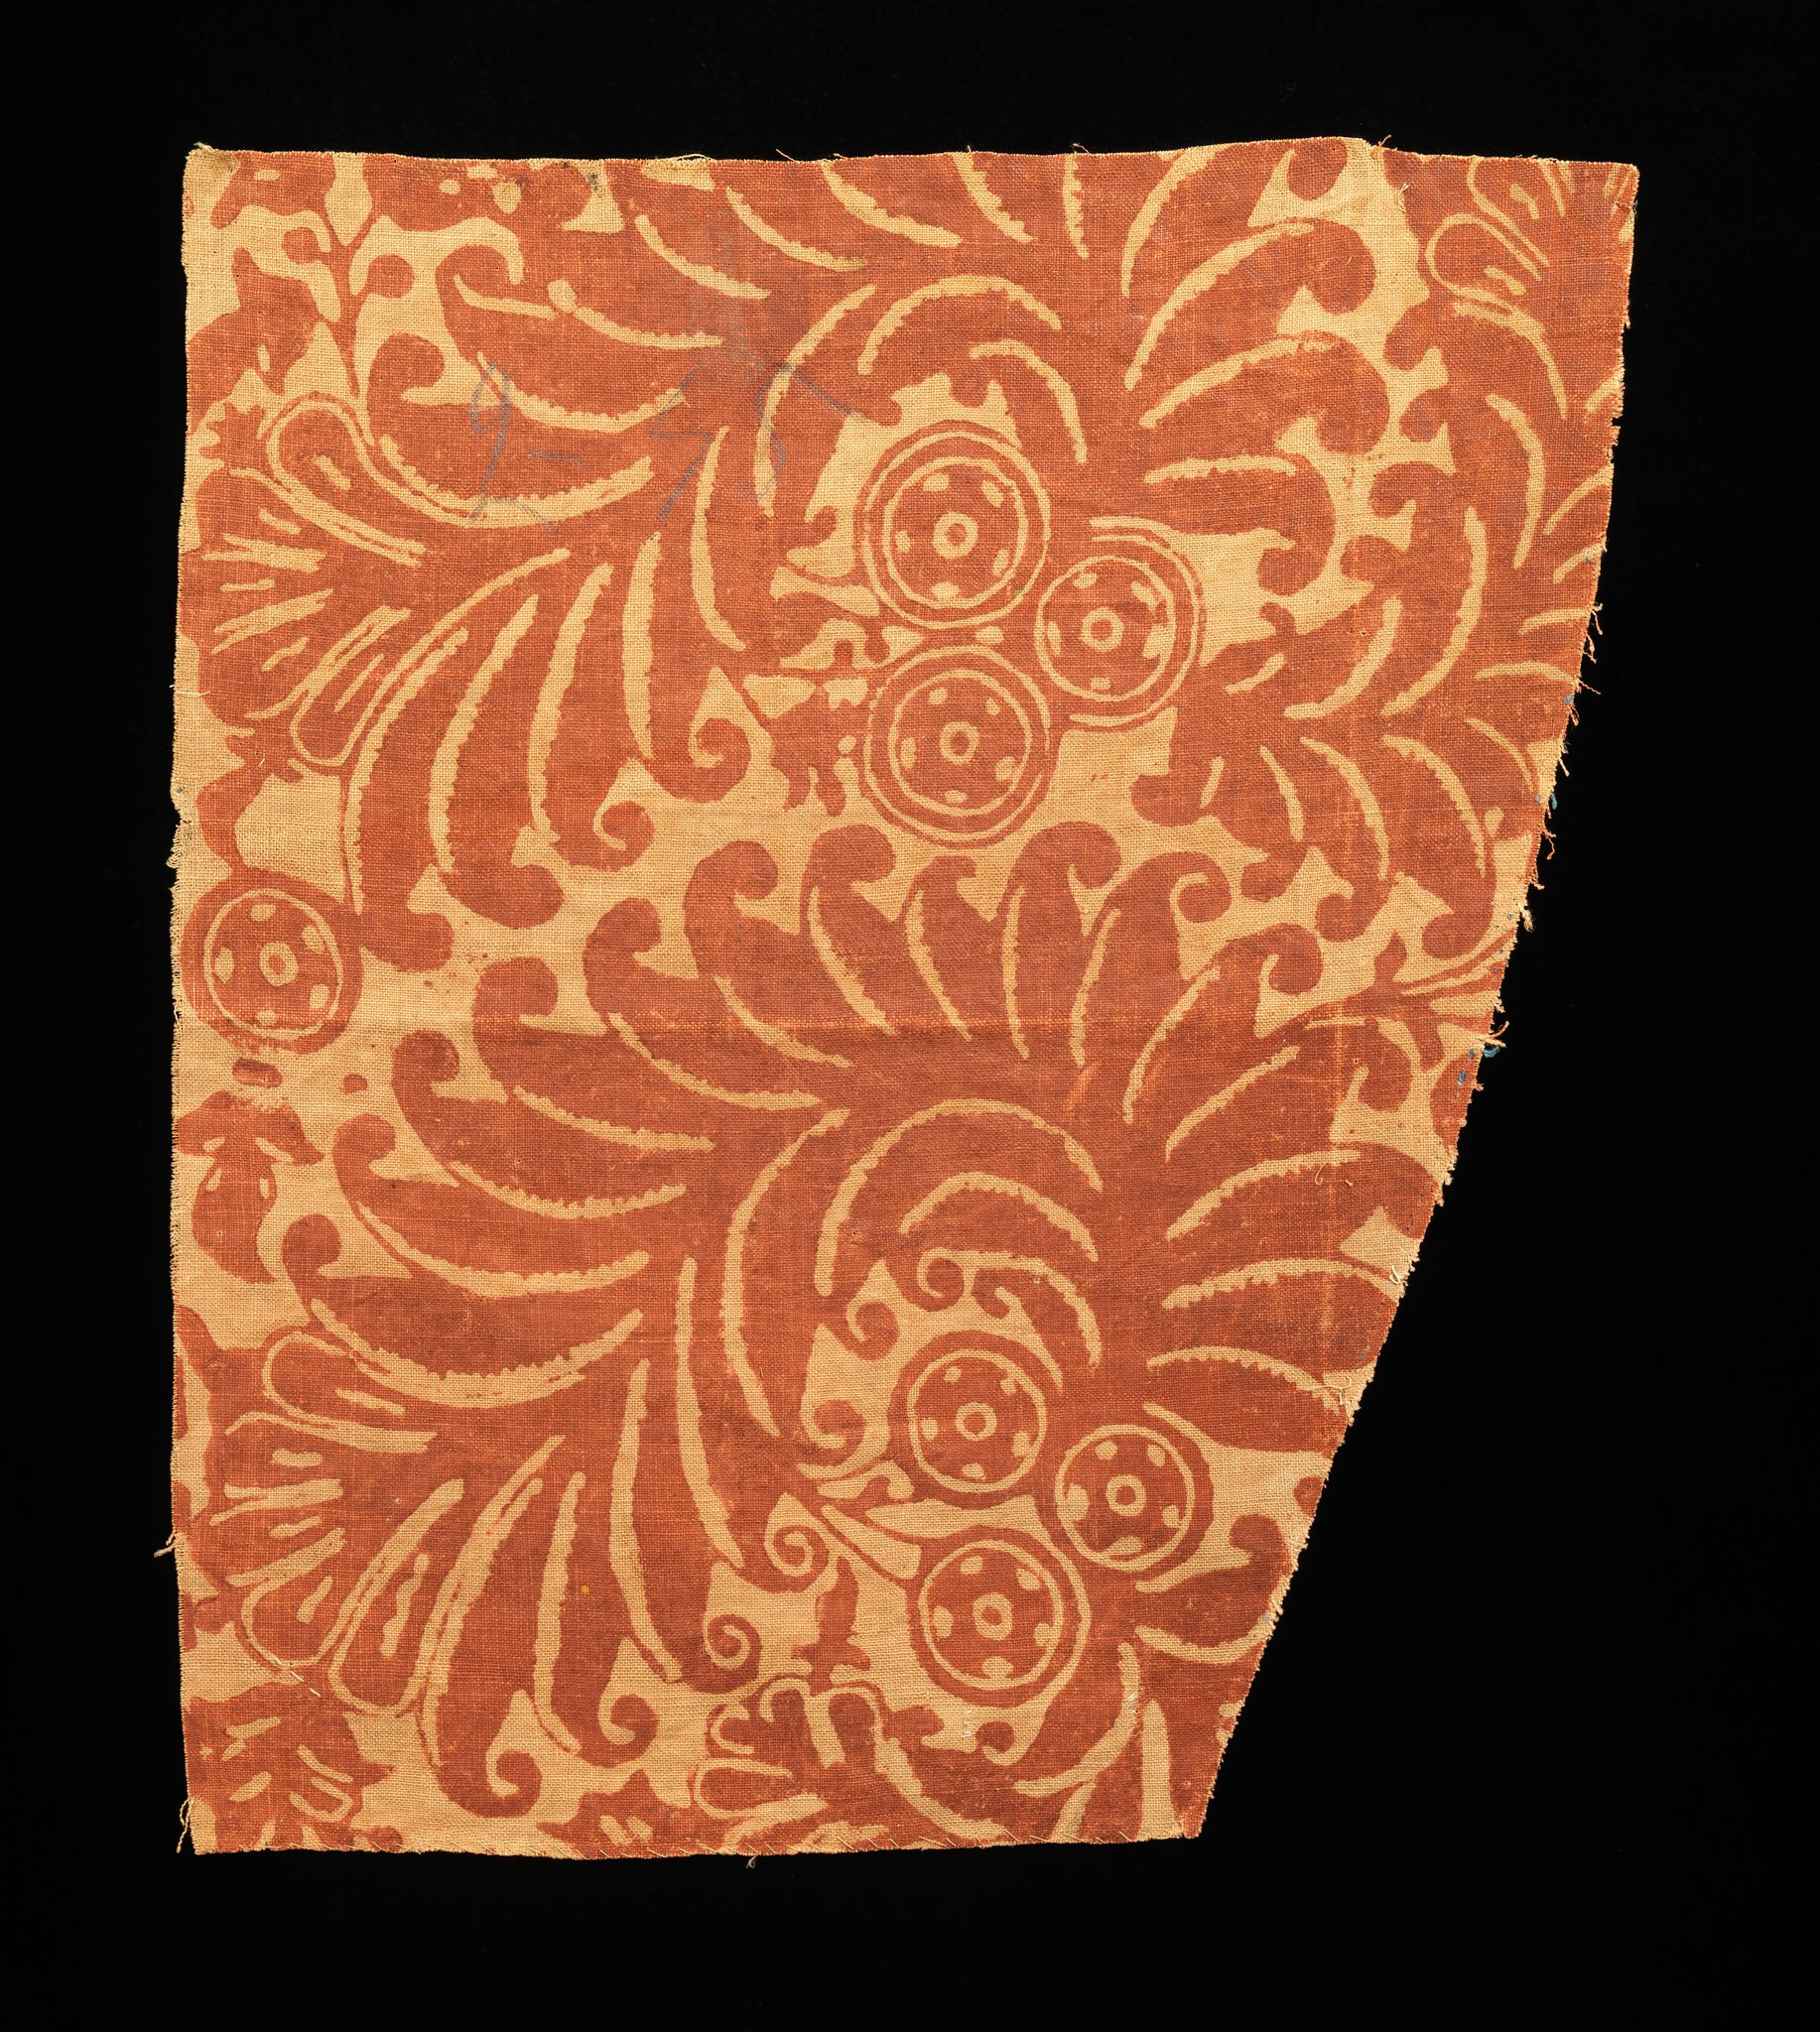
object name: textile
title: Textile fragment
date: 1700-1899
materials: linen